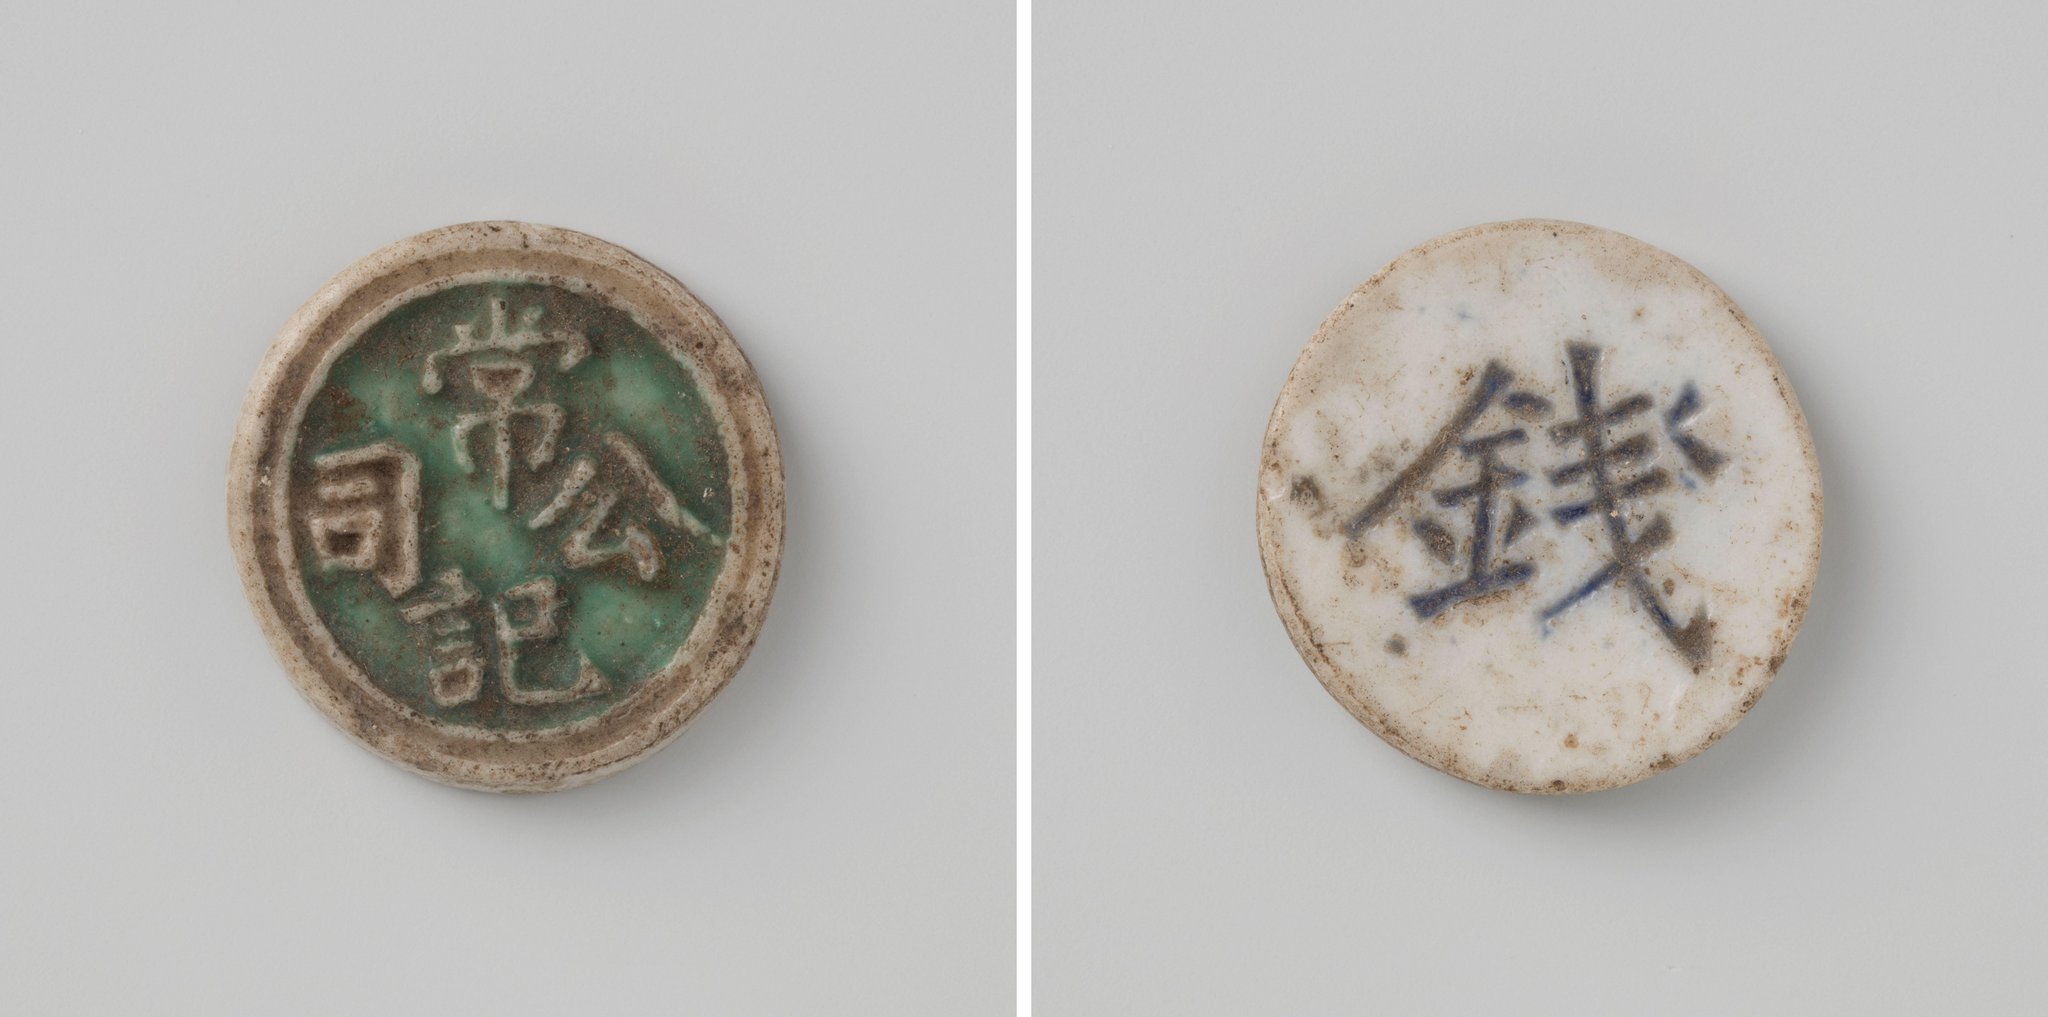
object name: coin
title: Thailand, speelhuispenning uitThailand ter waarde van een salung, 1760-1871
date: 1760-1871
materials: porcelain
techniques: firing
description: Ronde porseleinen speelhuispenning, die ook als munt is gebruikt. Voorzijde: vier Chinese karakters. Keerzijde: een Chinees karakter.